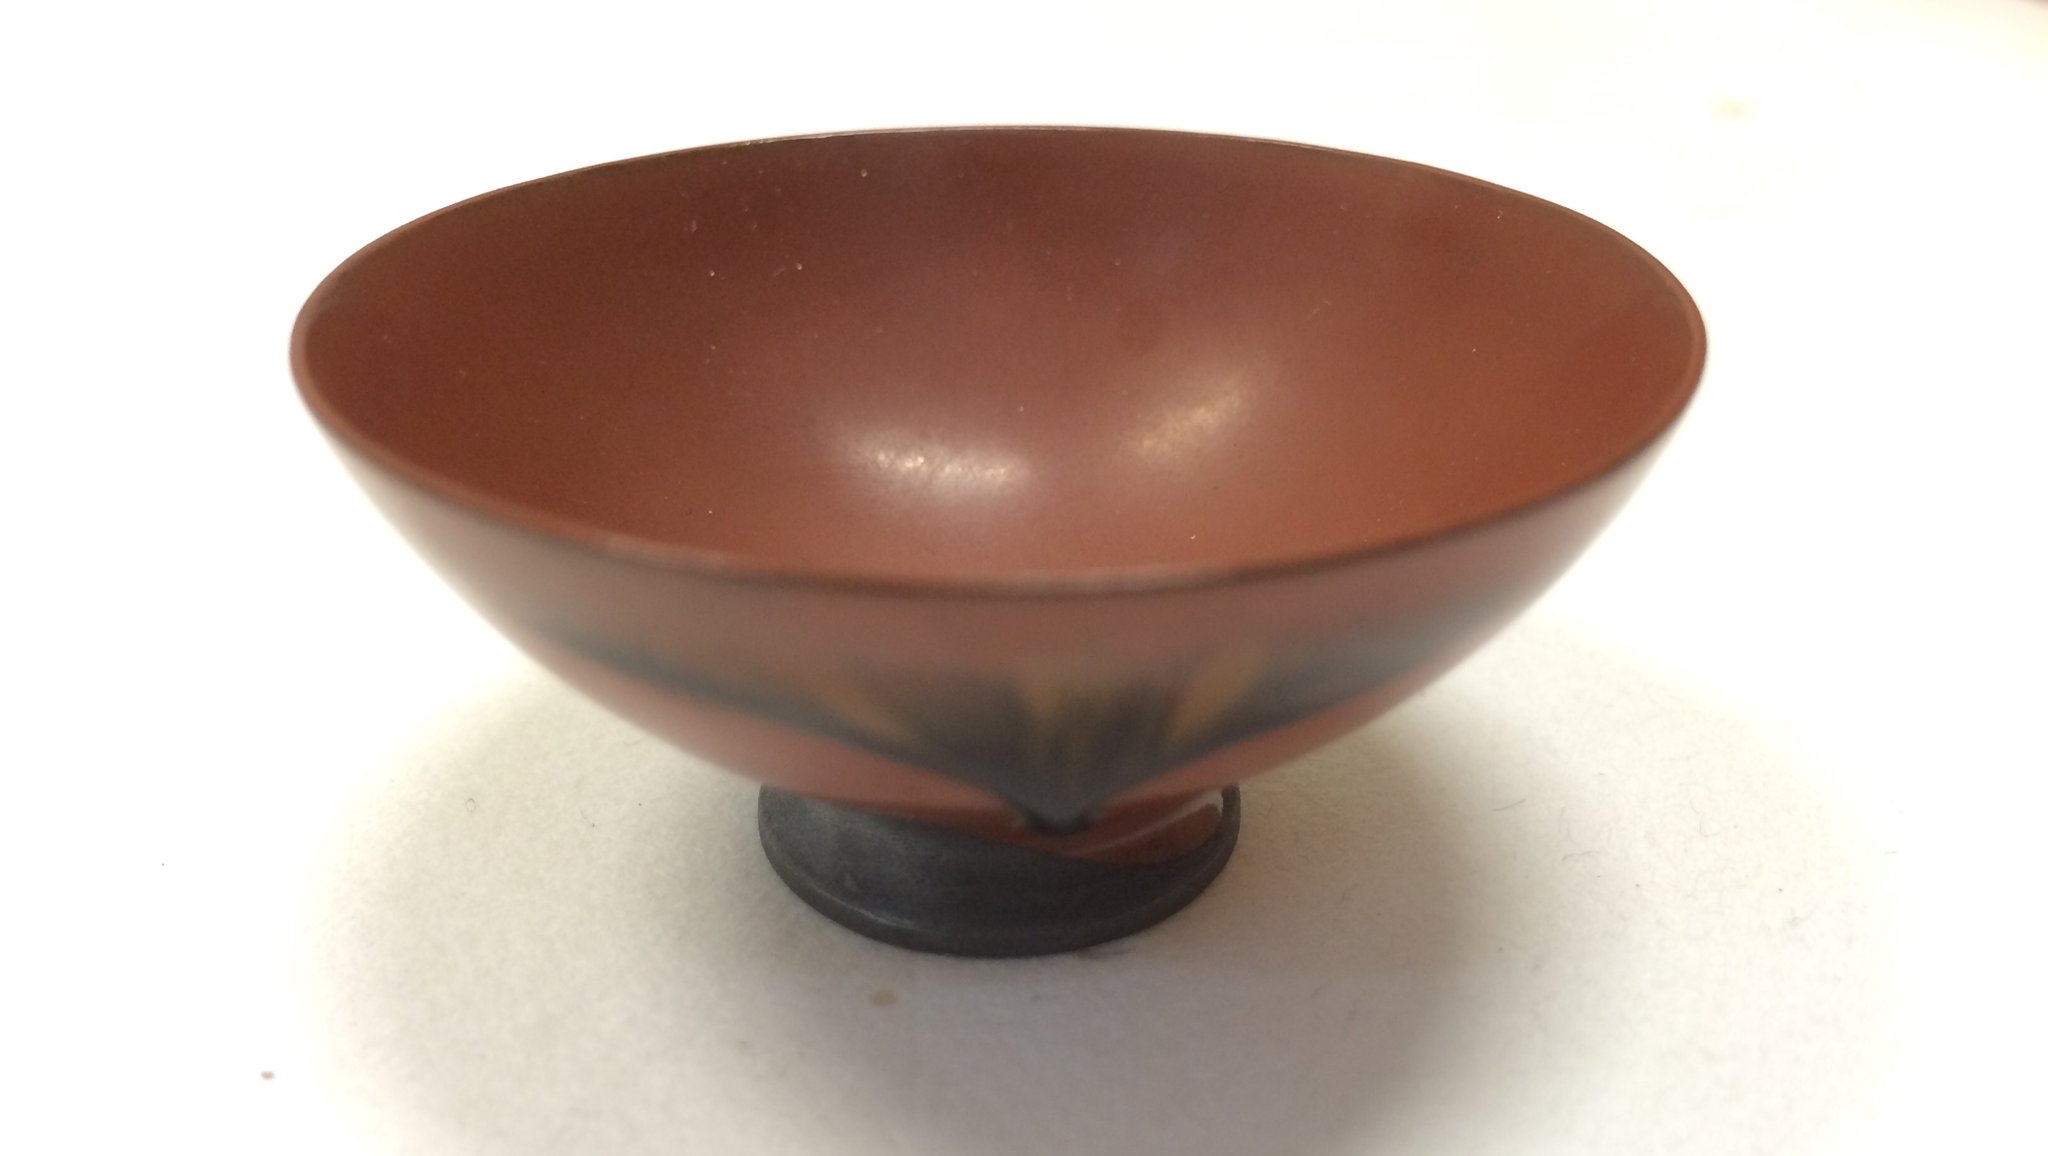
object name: wine cup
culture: japanese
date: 1834-1866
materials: lacquer